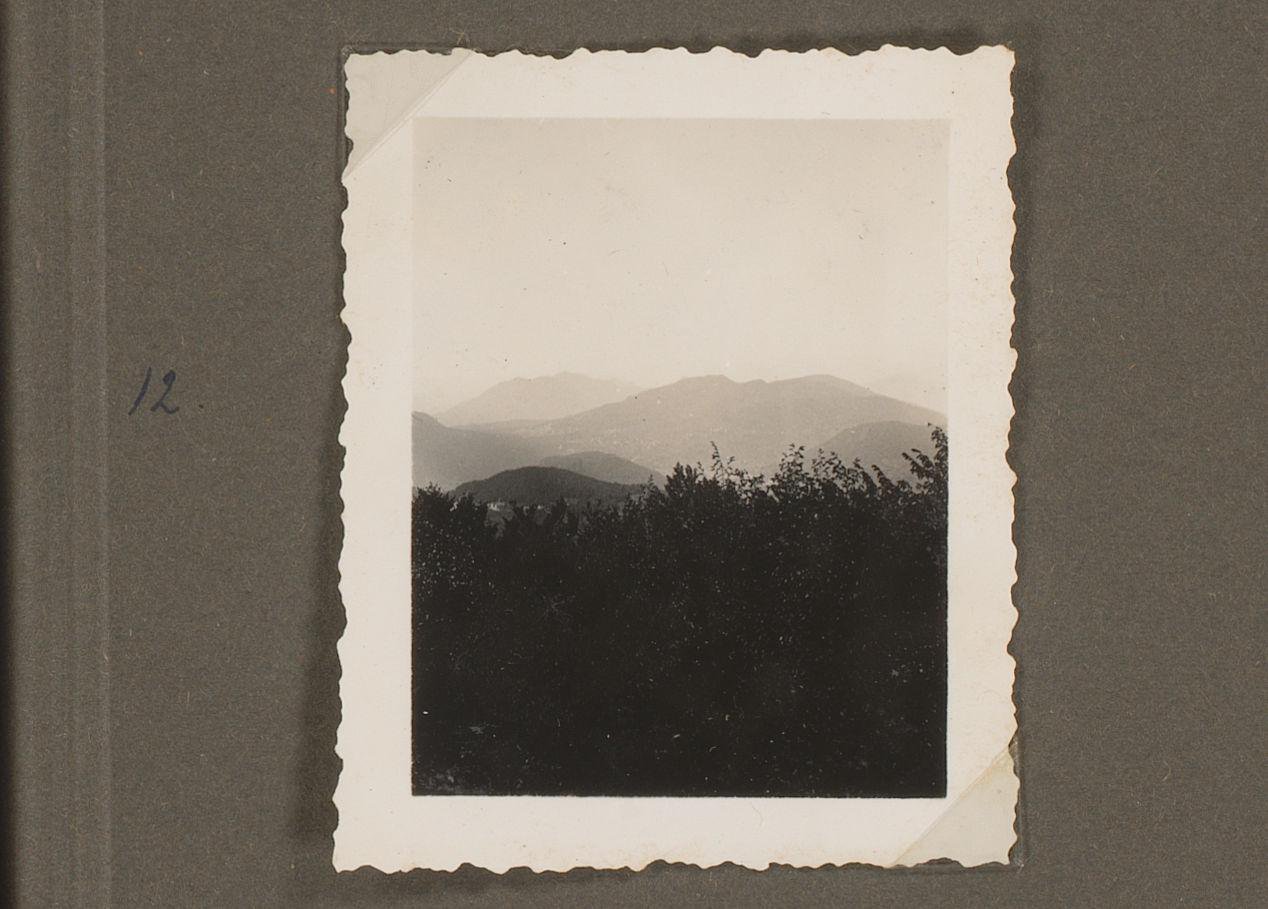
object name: photograph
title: Bergen in de verte, gezien vanaf de Monte San Salvatore, Zwitserland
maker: Anonymous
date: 1934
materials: photographic support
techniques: gelatin silver print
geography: monte san salvatore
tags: mountains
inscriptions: number: ‘12’